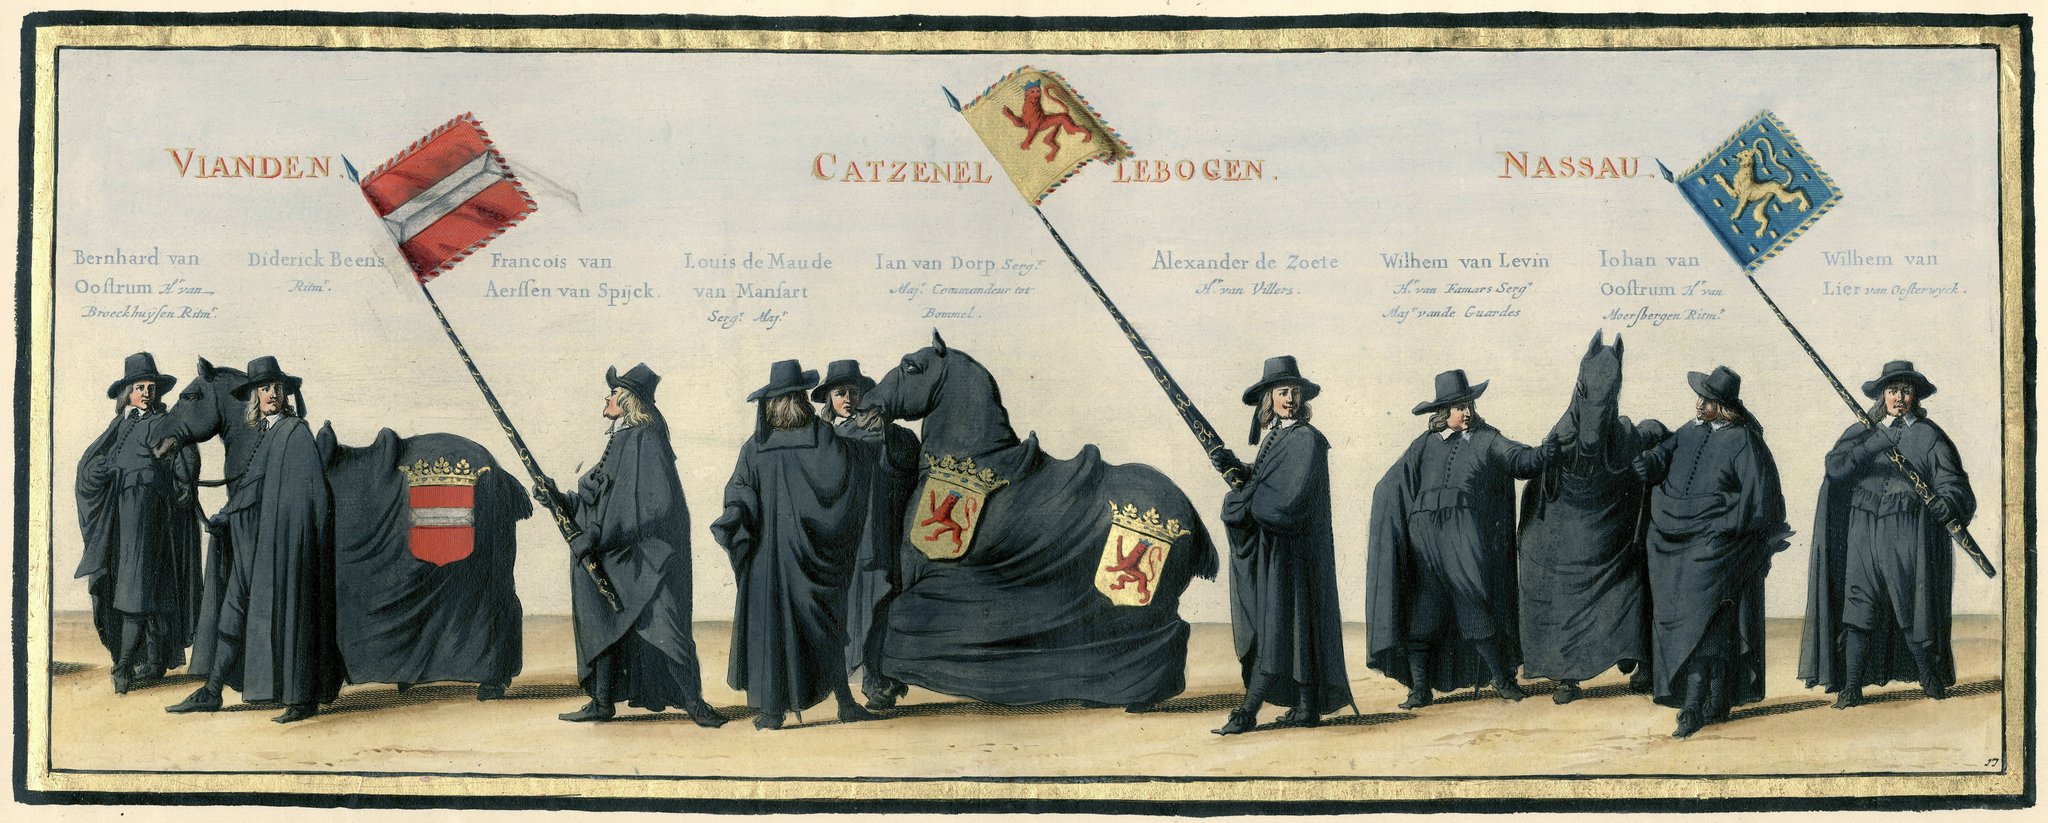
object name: print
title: De begrafenisstoet van Frederik Hendrik, plaat nr. 17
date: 1651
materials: paint, paper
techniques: colour, etching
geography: amsterdam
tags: delft, the hague, frederick henry (prince of orange)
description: De begrafenisstoet van Frederik Hendrik, plaat nr. 17. Ingekleurde prent in een omlijsting versierd met goud en ingeplakt in de luxe editie uit ca. 1755 van het boek 'Begraeffenisse van syne hoogheyt Frederick Henrick' van Pieter Post, uitgegeven te Amsterdam in 1651.